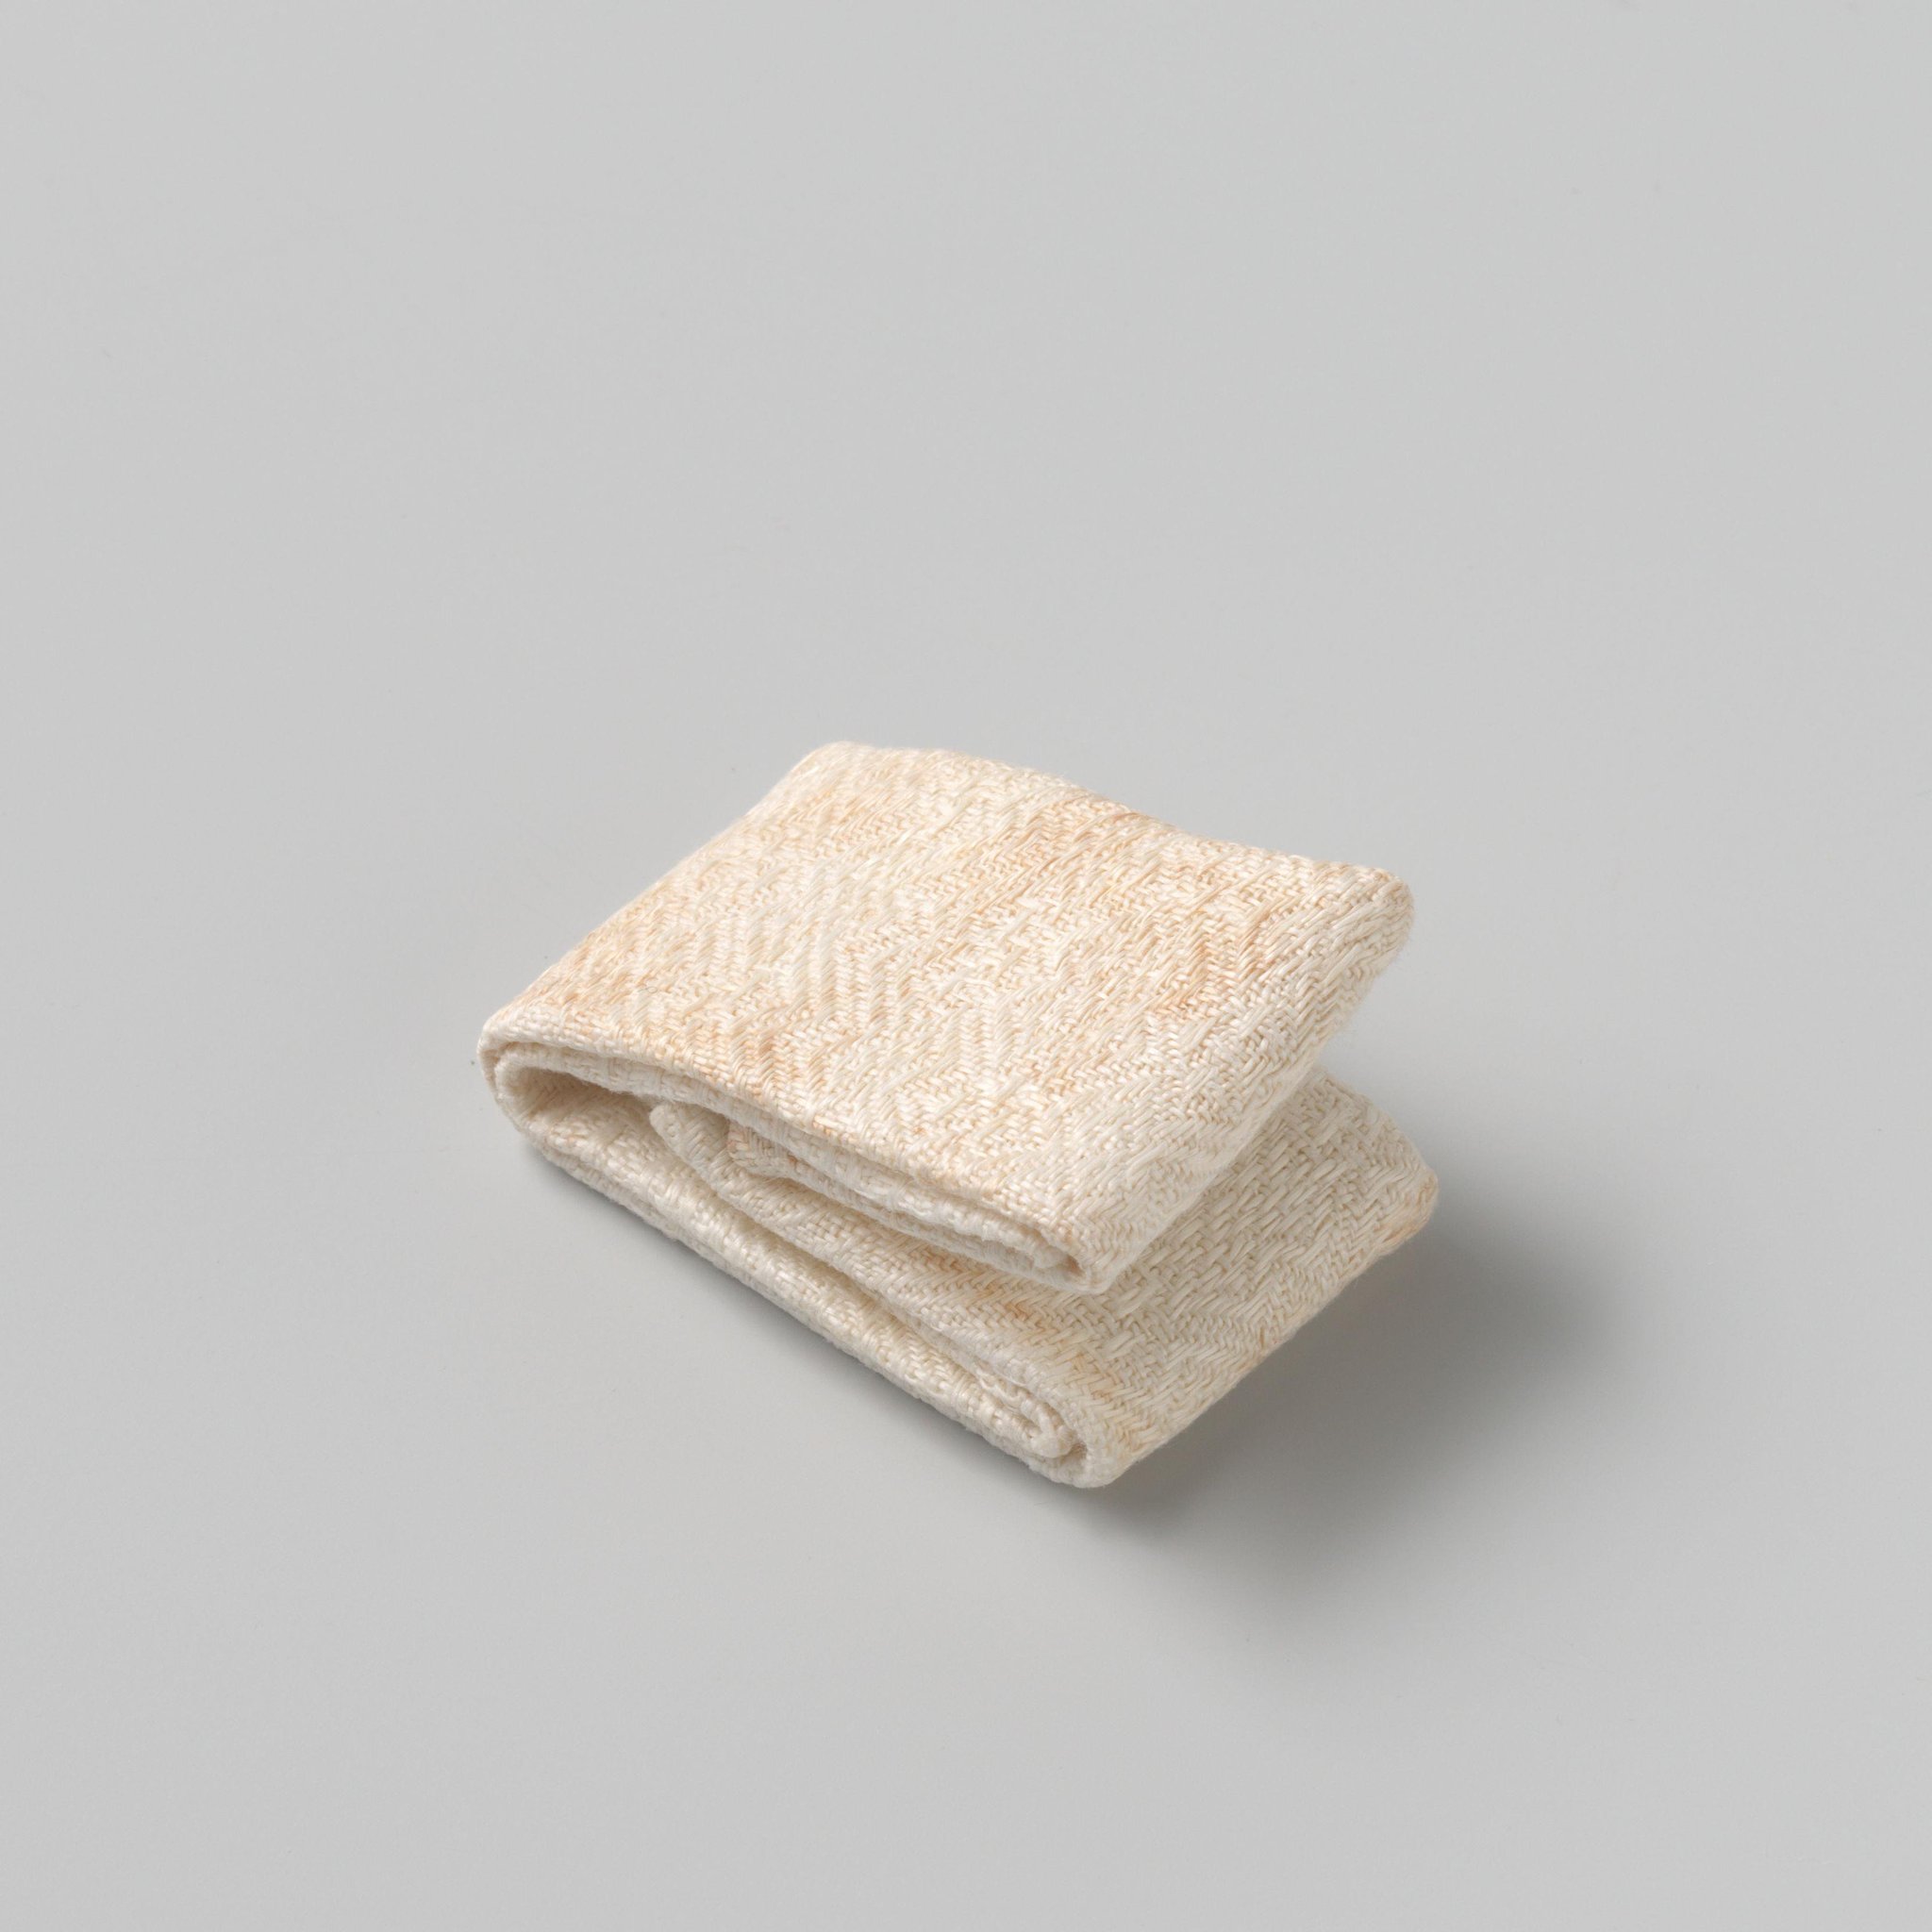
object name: napkin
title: Servet, damastweefsel met pellenpatroon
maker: Anonymous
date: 1600-1699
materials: linen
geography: netherlands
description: Servet, damastweefsel met een pellenpatroon, geknipt uit grotere stukken linnen en aan alle kanten omgezoomd met een fijne zoom.